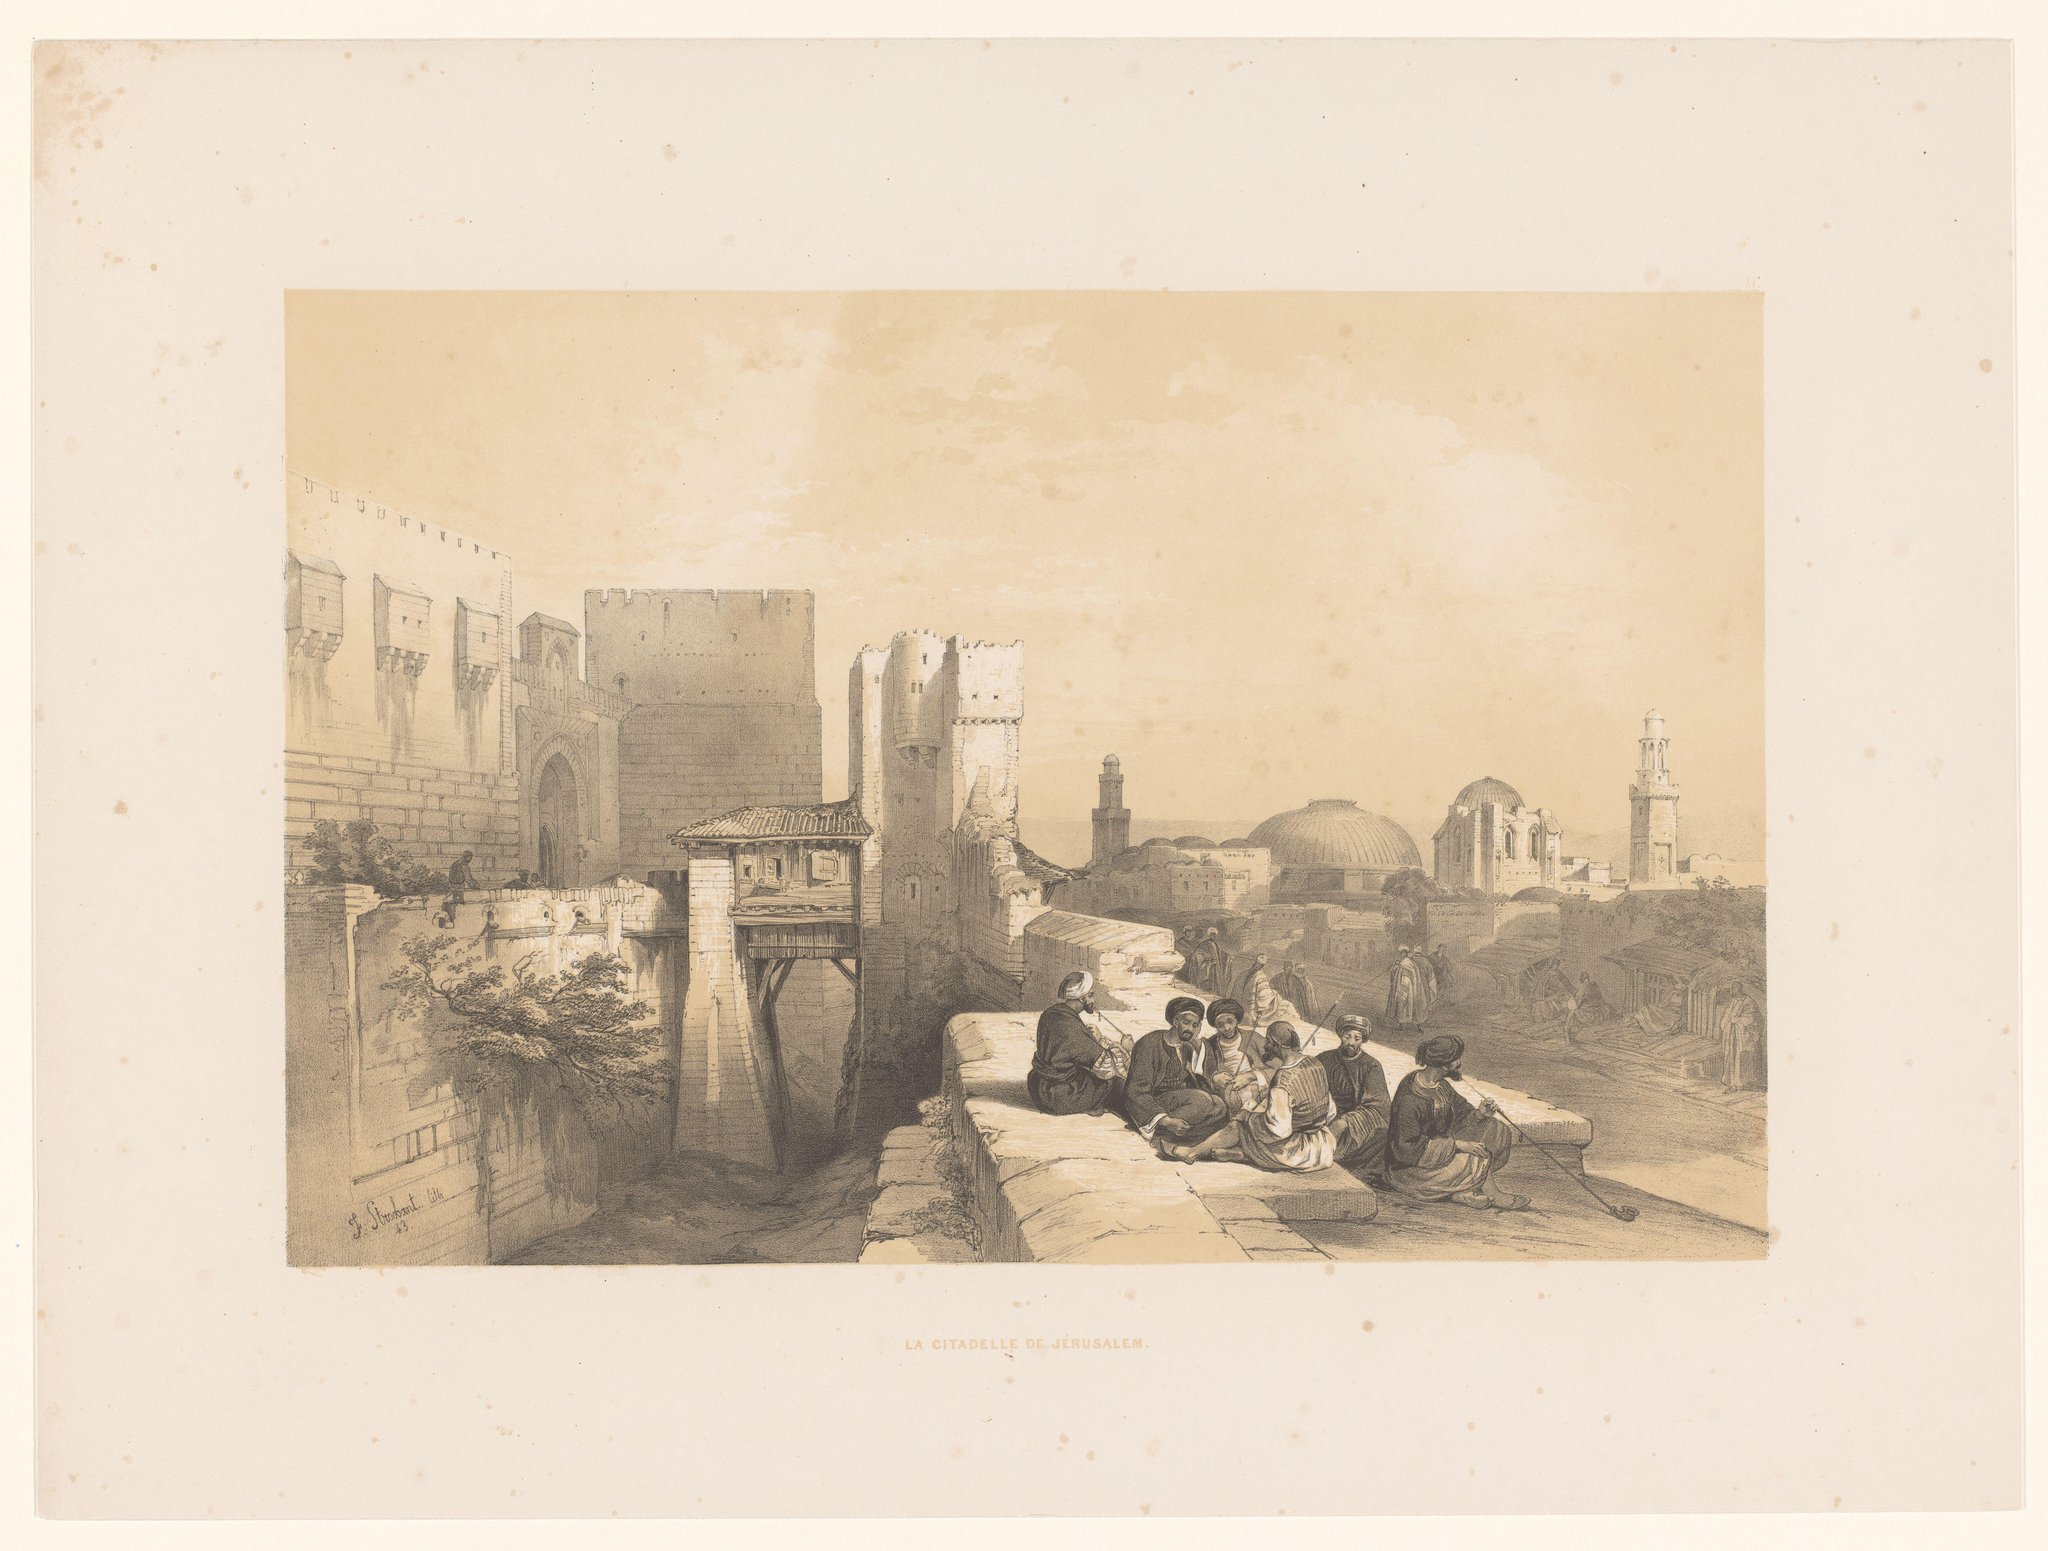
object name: print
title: Gezicht op Jeruzalem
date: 1852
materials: paper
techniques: tone lithography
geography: brussels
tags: pipe ~ tobacco, city-walls, city-view in general; 'veduta' (+ city(-scape) with figures, staffage)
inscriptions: collector's mark: Lugt 2228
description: Jules Géruzet maakt in 1852 een heruitgave van het Belgische werk 'La terre sainte. Vues et monuments recueillis par David Roberts de l'Académie de Londres' dat tussen 1843-1845 wordt gedrukt door J. Lots en waarvan de prenten, op verzoek van de Société des Beaux-Arts, door Ghemar en Stroobant worden uitgevoerd naar werken van Haghe.